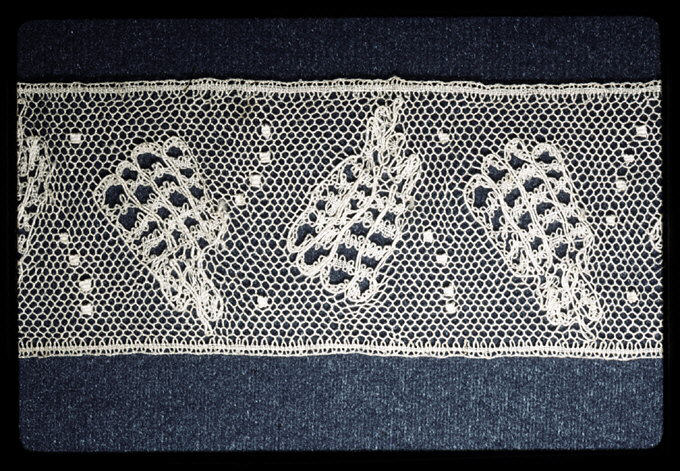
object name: insertion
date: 1830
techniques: lace